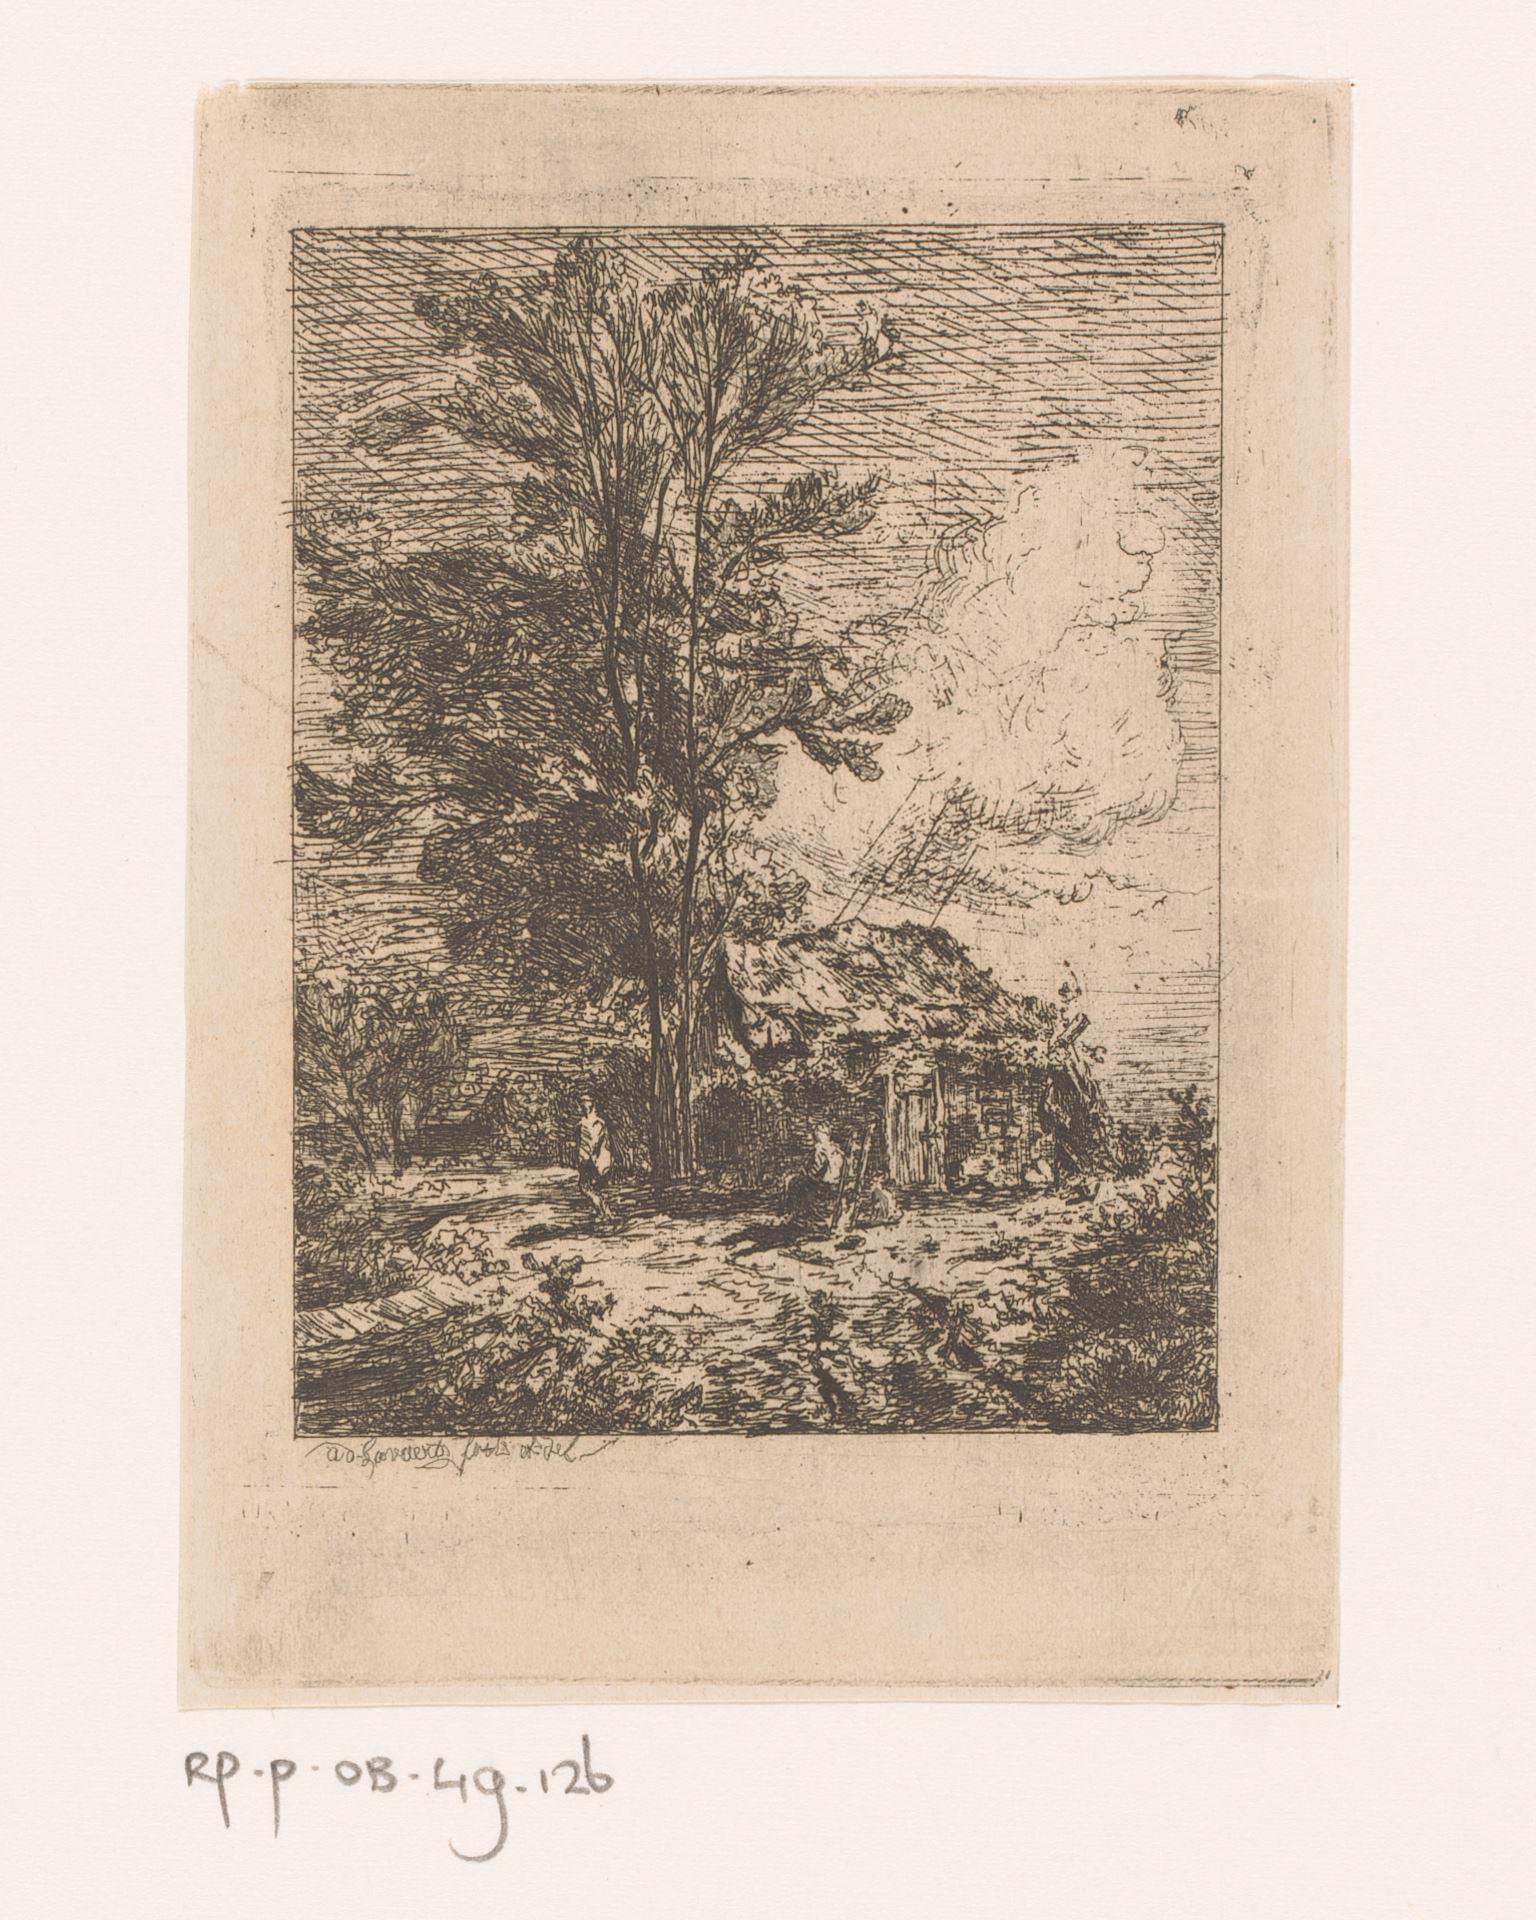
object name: print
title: Vervallen woning bij een boom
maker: adolf lavaerts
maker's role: print maker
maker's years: -1862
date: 1800-1862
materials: paper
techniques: etching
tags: farm or solitary house in landscape, neglected dwelling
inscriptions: collector's mark: Lugt 2228